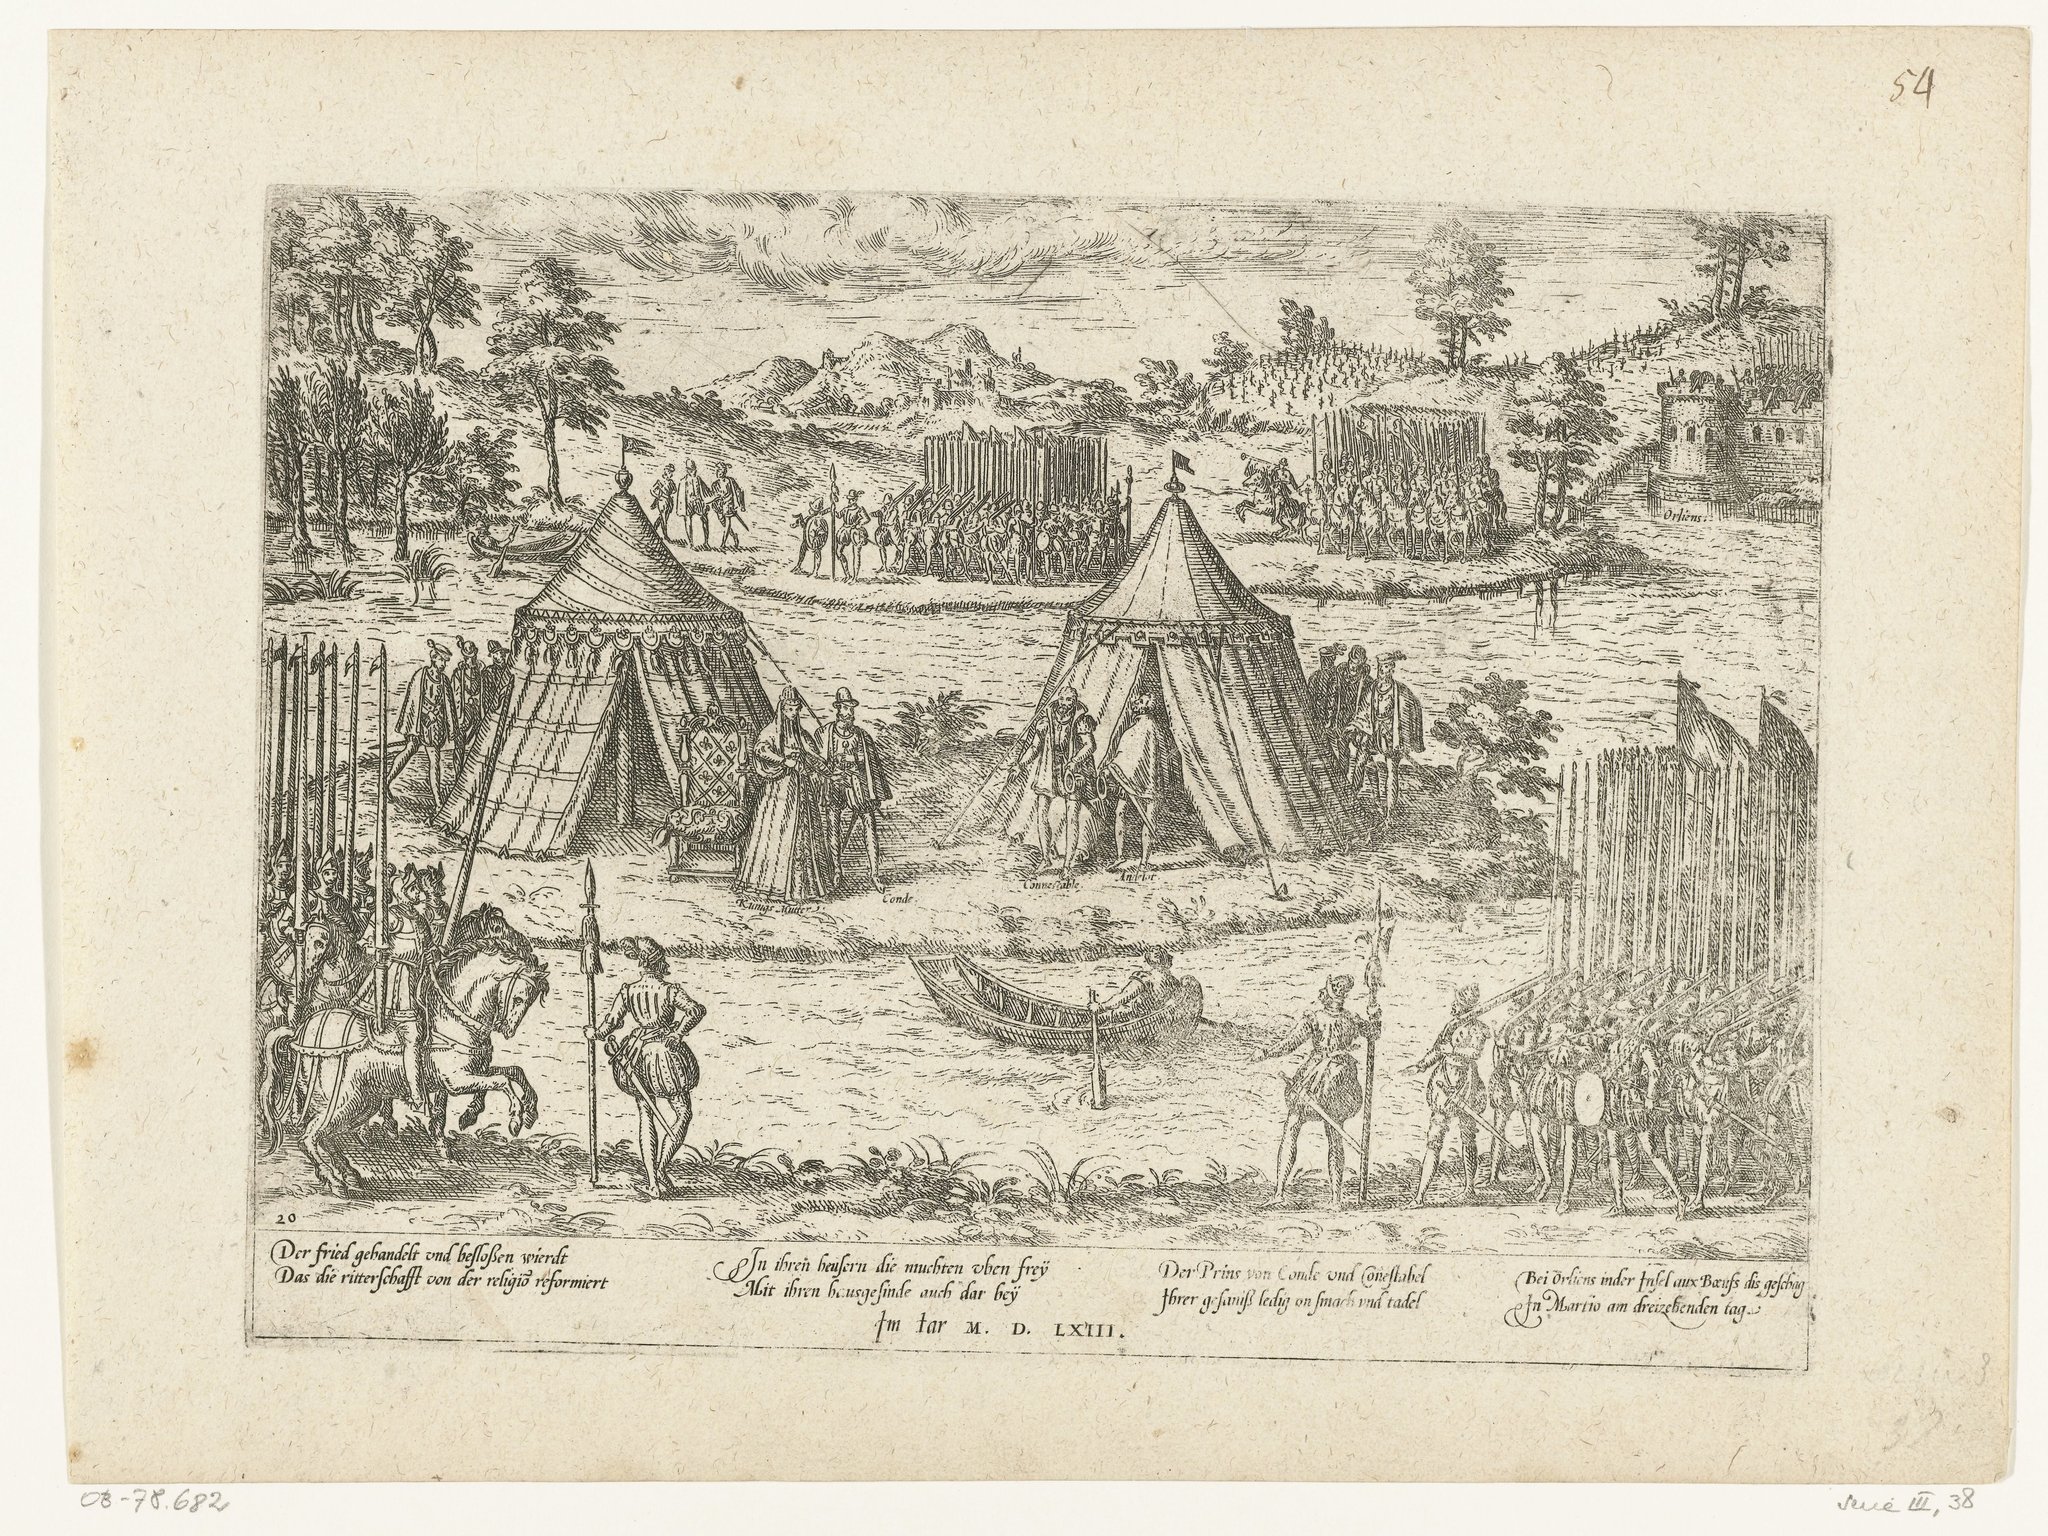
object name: print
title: Serie 3: Franse Godsdienstoorlogen, 1559-1573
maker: frans hogenberg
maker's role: print maker, publisher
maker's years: 1538-1590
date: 1565-1573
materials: paper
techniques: etching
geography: cologne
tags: signing of peace treaty, concluding the peace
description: Gekopieerd naar de prent in: Jean Tortorel et Jacques Perrissin, Premier volume contenant quarante tableaux ou Histoires diverses qui sont memorables touchant les Guerres, Massacres et Troubles advenus en France en ces dernieres annees : le tout recueilly selon le tesmoignange de ceux qui y ont esté en personne et qui les ont veus : lesquels sont pourtraits à la vérité, Genève ca. 1570. Bibliotheek Rijksmuseum: 329 A 2, pl. 25.